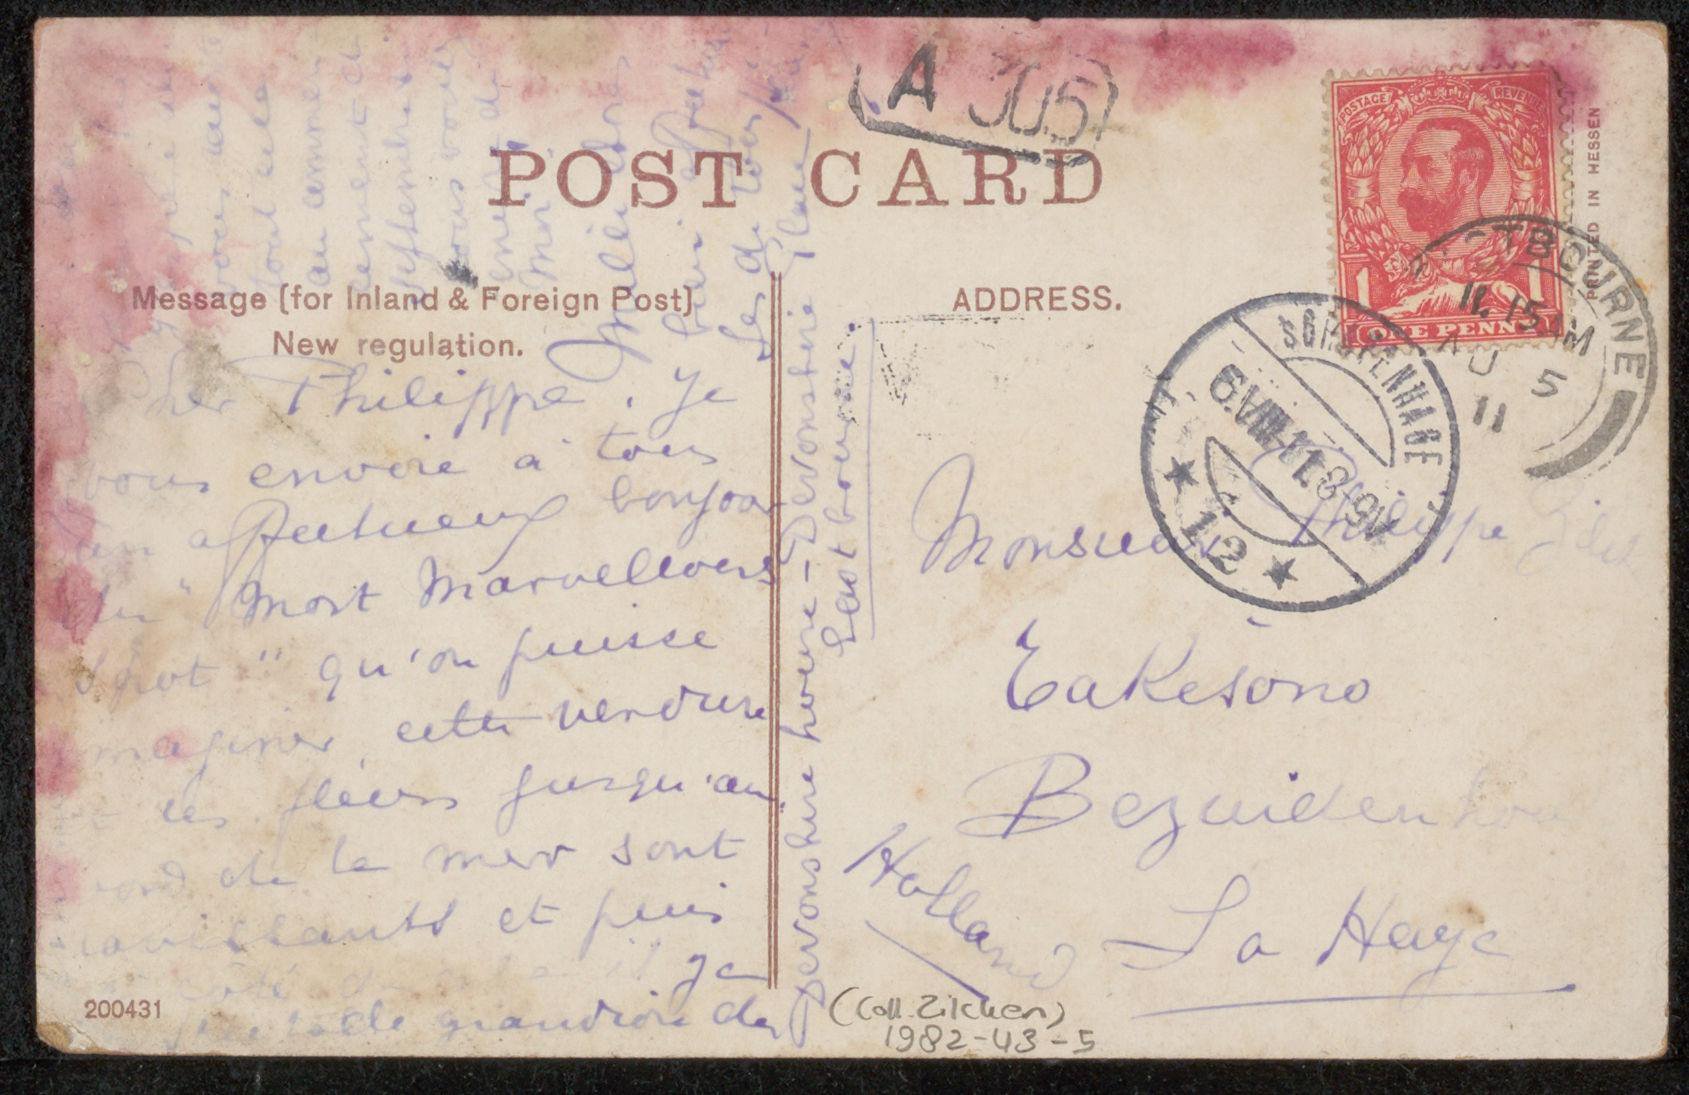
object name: ansichtkaart, prentbriefkaart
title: Prentbriefkaart aan Philip Zilcken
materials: cardboard, ink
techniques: pen, printing, writing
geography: hessen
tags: painter, draughtsman, philip zilcken